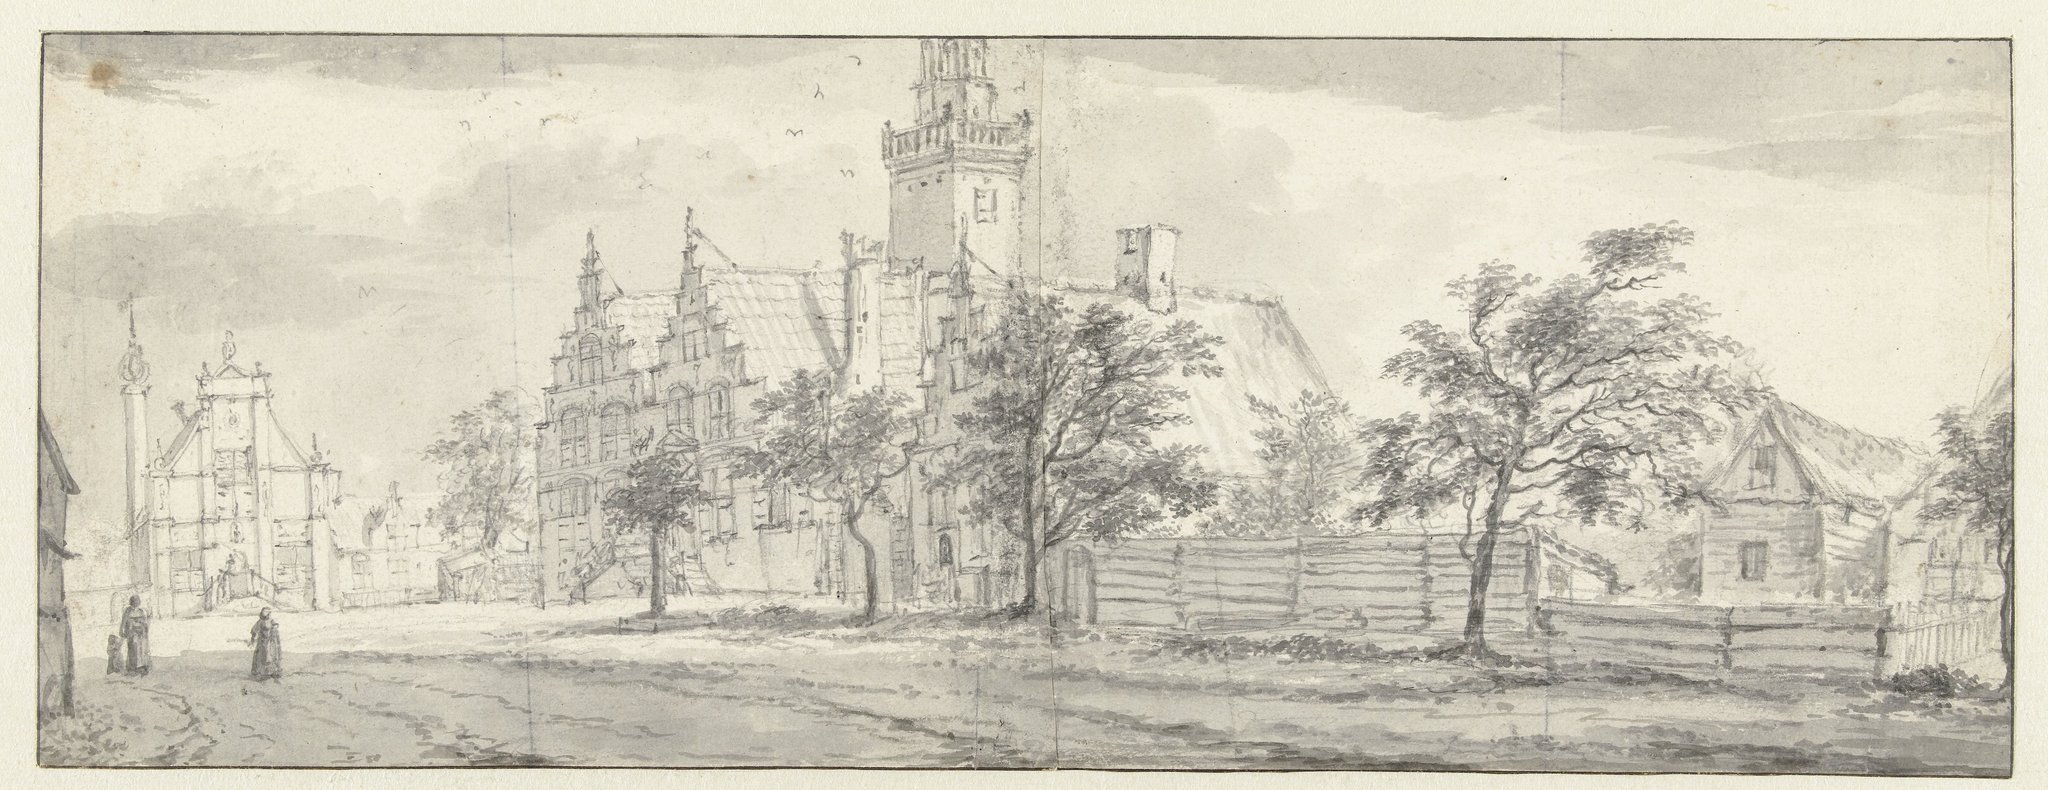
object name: drawing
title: Gezicht op Nieuwkoop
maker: jan abrahamsz. beerstraten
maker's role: draughtsman, painter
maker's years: 1622-1666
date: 1600-1699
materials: chalk, graphite, paper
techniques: brush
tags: street (+ city(-scape) with figures, staffage)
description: Gezicht op Nieuwkoop met links het Reghthuys en rechts naast de trapgevelhuizen de toren van het Hoge Huys.